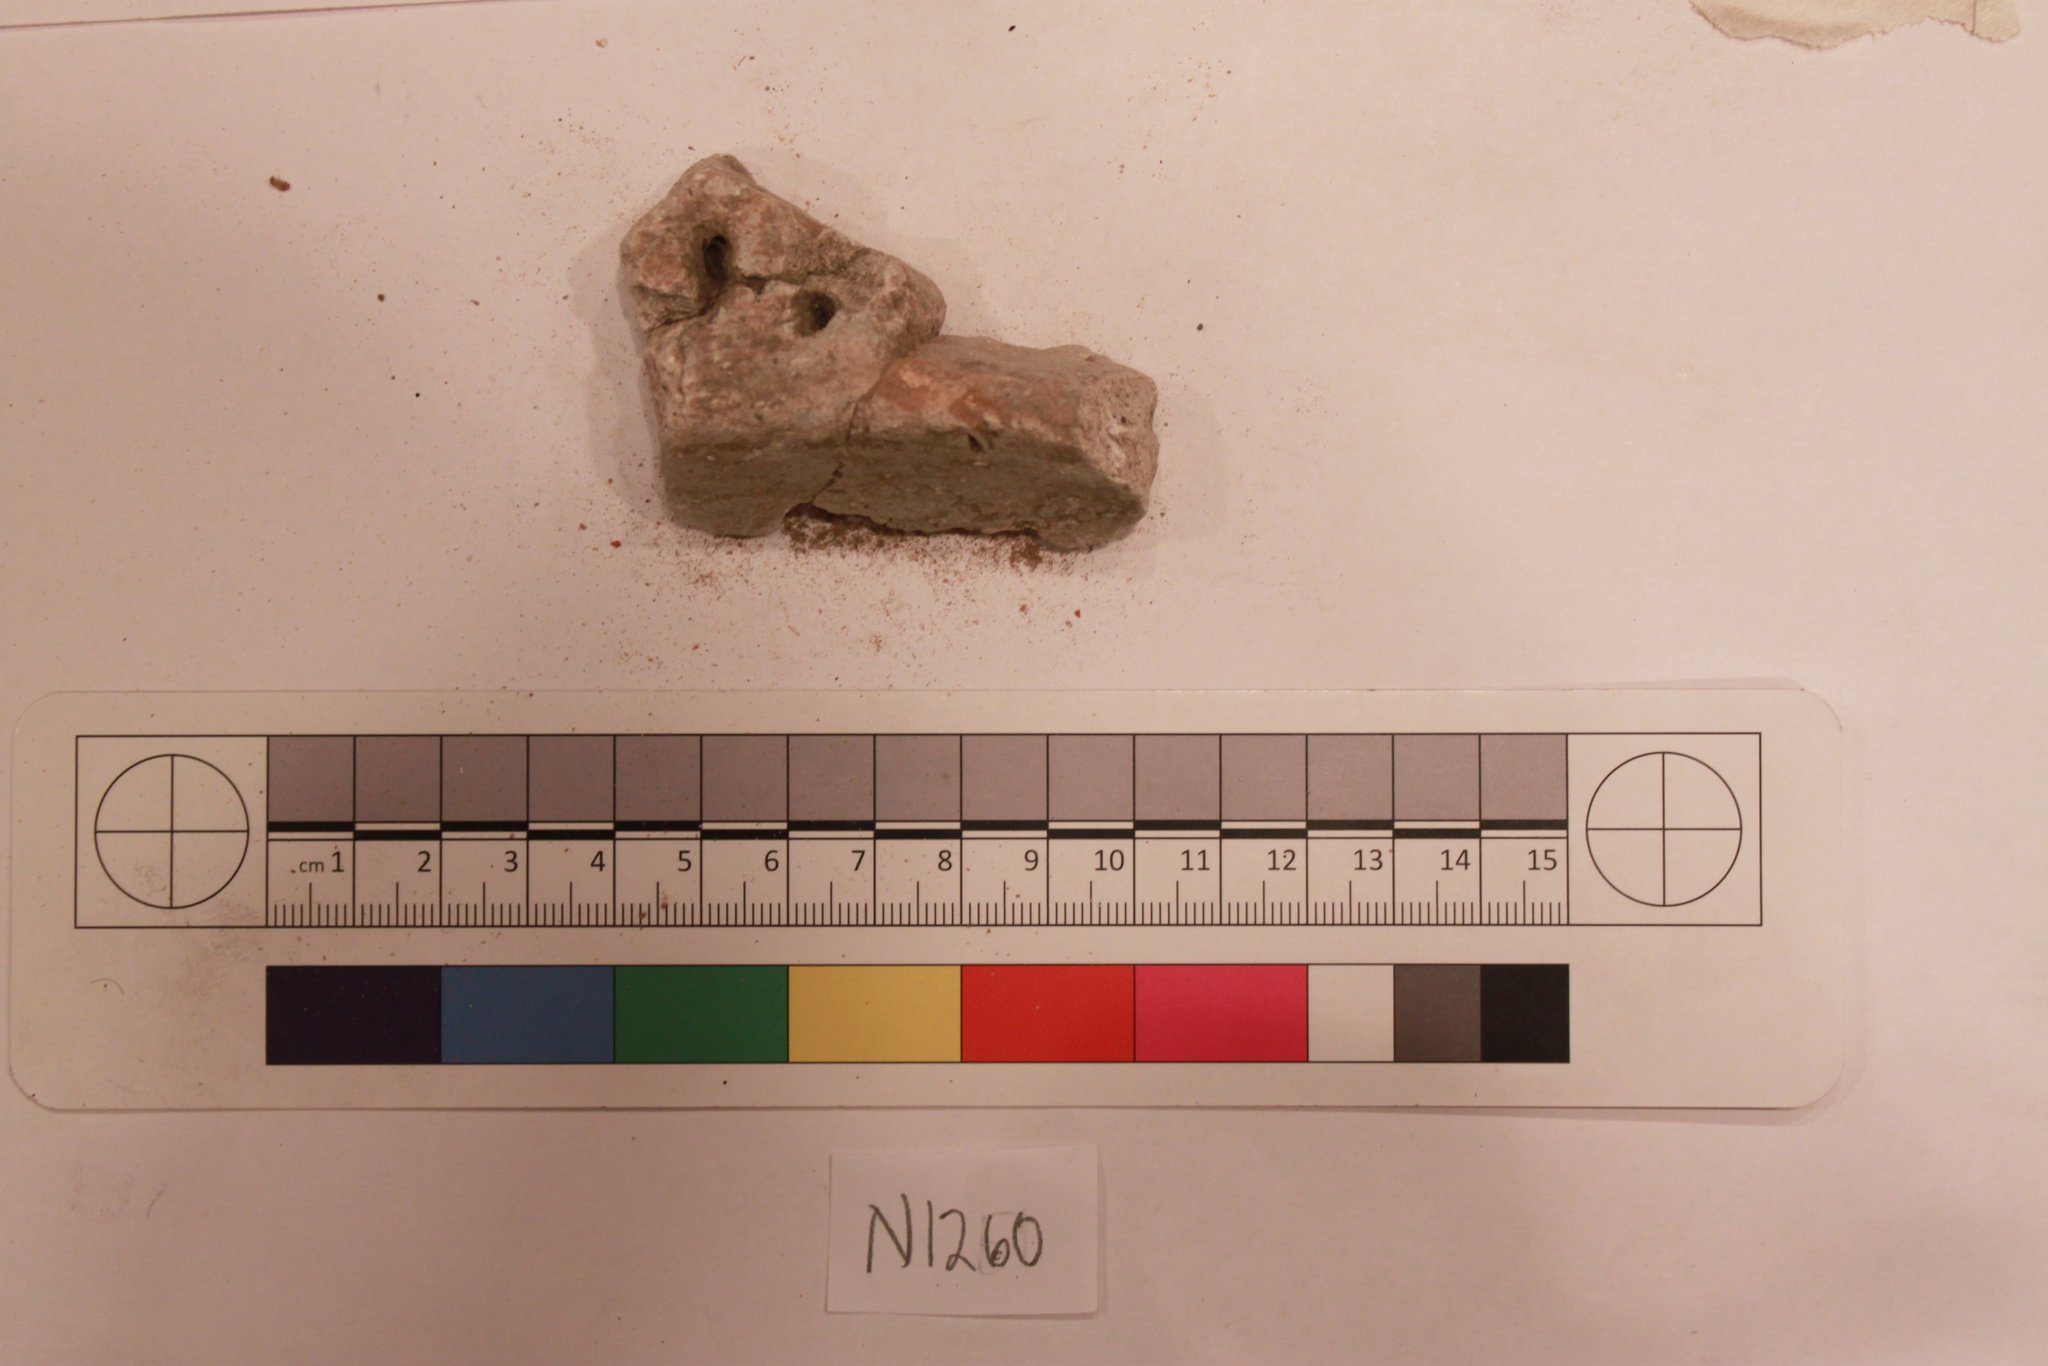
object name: fragment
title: Stucco Fragment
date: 701-1200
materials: plaster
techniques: carving, painting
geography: iran